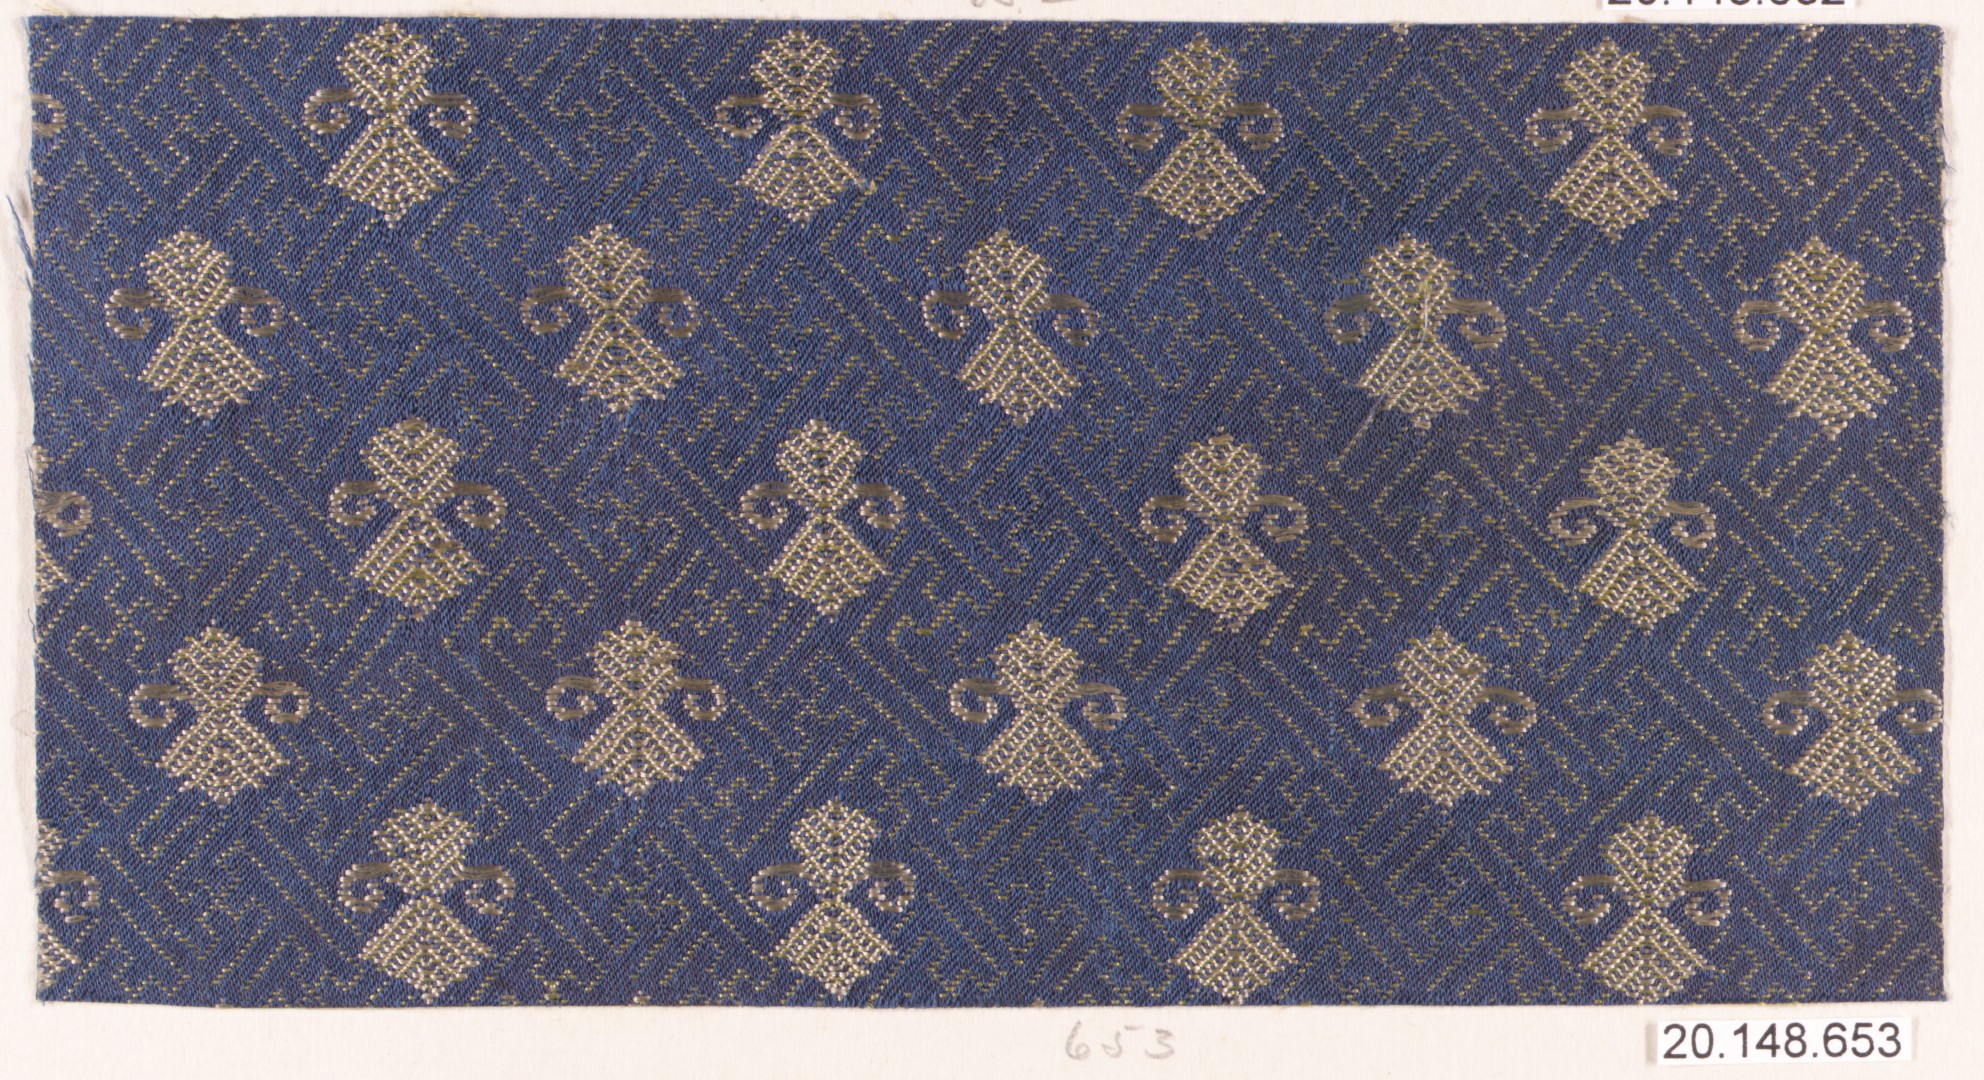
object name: piece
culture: japanese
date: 1701-1800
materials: silk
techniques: compound weave